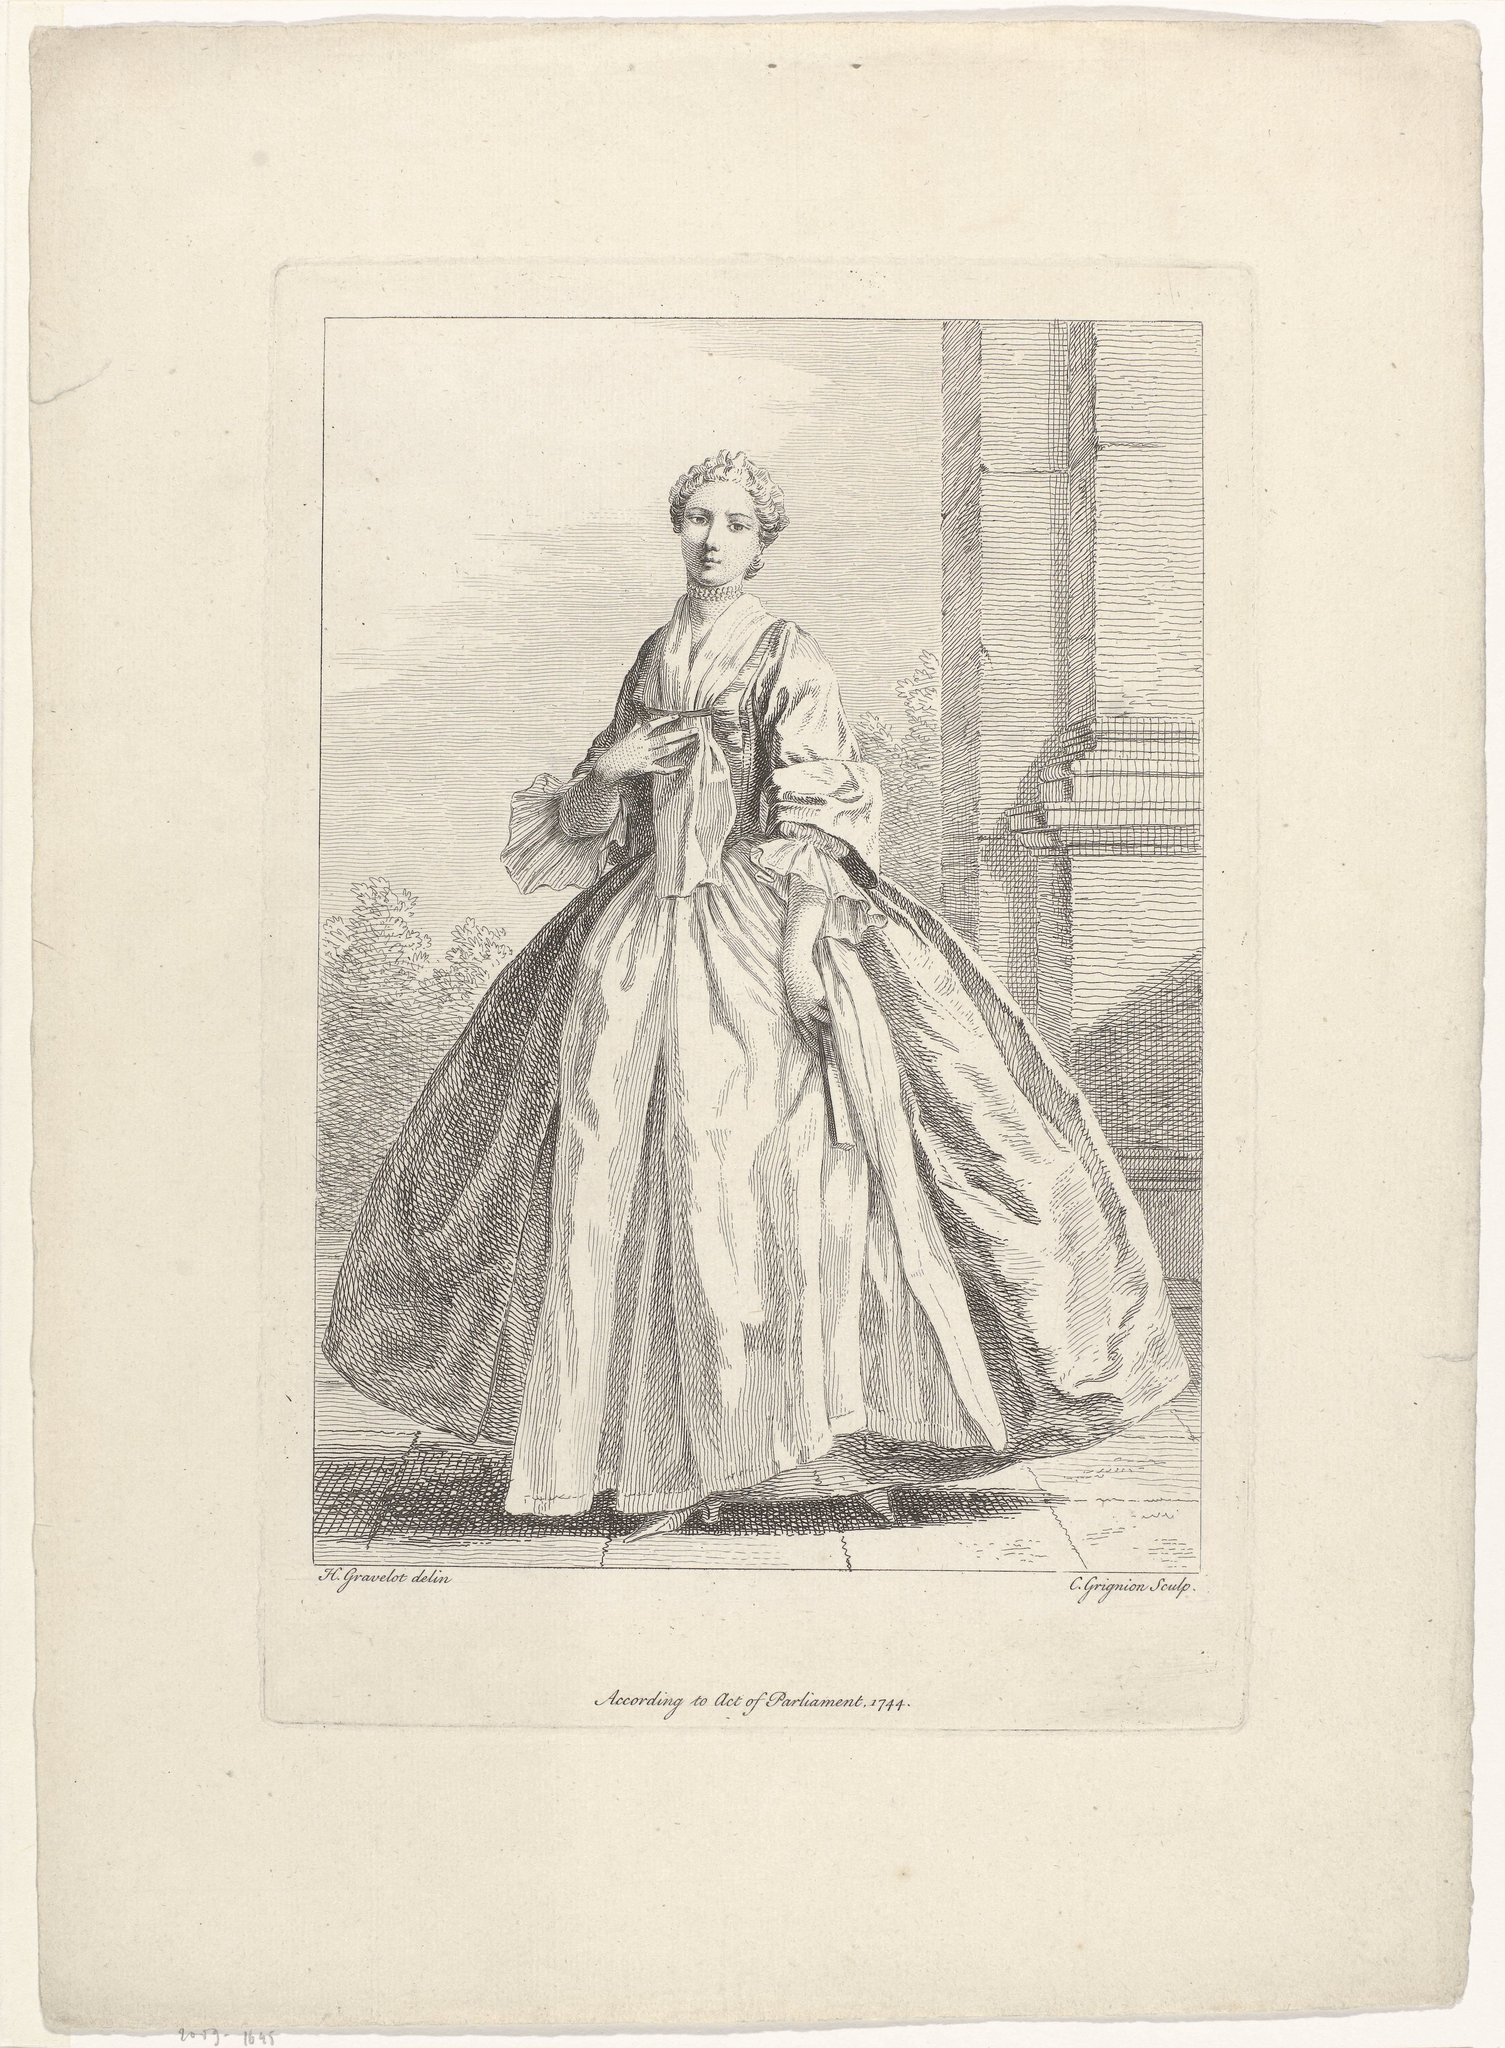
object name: costume print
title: Estampes de costumes, 1744, Pl. 4 (507)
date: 1744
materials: paper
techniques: etching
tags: fashion plates, dress, gown (+ women's clothes)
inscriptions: date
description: Staande vrouw op bordes, van voren gezien